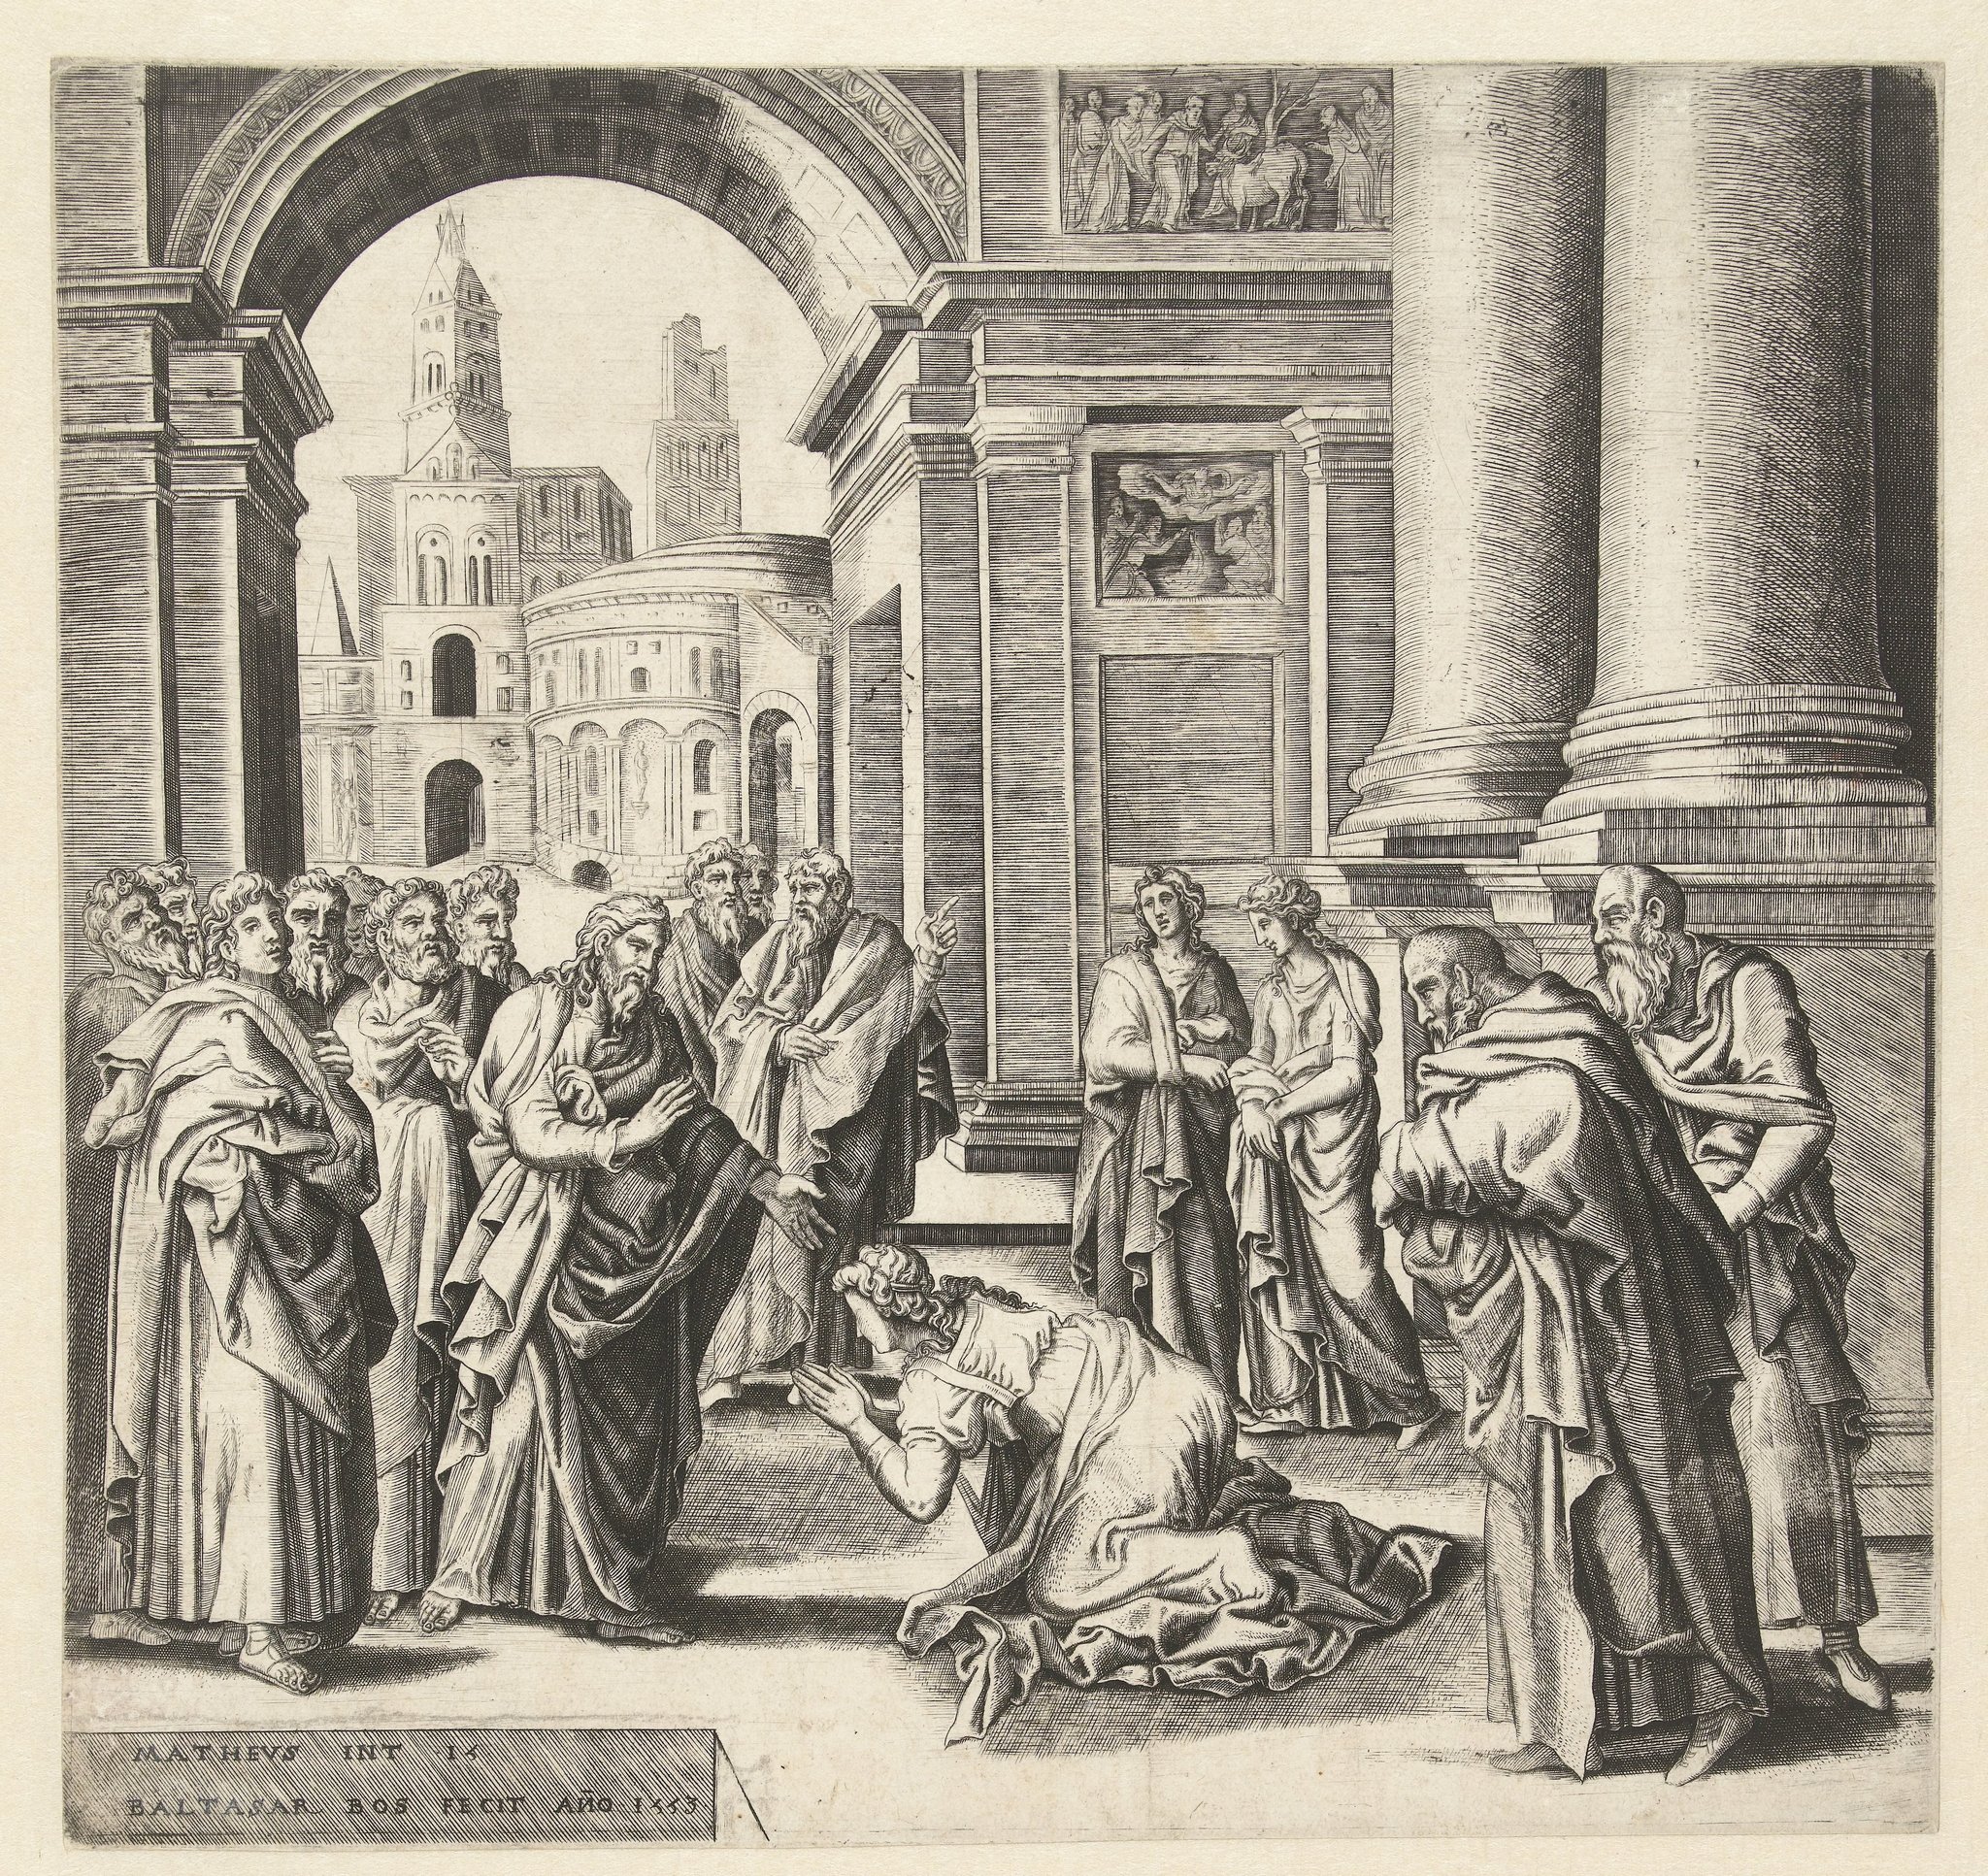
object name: print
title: Christus en vrouw van Kanaän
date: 1553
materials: paper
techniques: engraving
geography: antwerp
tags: a canaanite woman kneels before christ, asking him to heal her daughter; the metaphor of the dogs and bread (matthew 15:21-28; mark 7:24-30)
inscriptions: collector's mark: Lugt 2228, collector's mark: Lugt 2760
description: Op een plein in een stad wordt Christus benaderd door een Kanaänitische vrouw. Ze knielt en smeekt hem haar dochter te genezen . Hoewel de apostelen rond Christus aanraden de vrouw weg te sturen, praat Christus met de vrouw en prijst haar standvastig geloof. Daarna roept hij uit dat haar dochter is genezen. (Matteus 15:21-28). De prent toont de twaalf apostelen, Christus, Maria en Maria Magdalena en de overspelige vrouw. In de achtergrond een poort met relief. De prent heeft een onderschrift met referentie naar bijbelplaats.